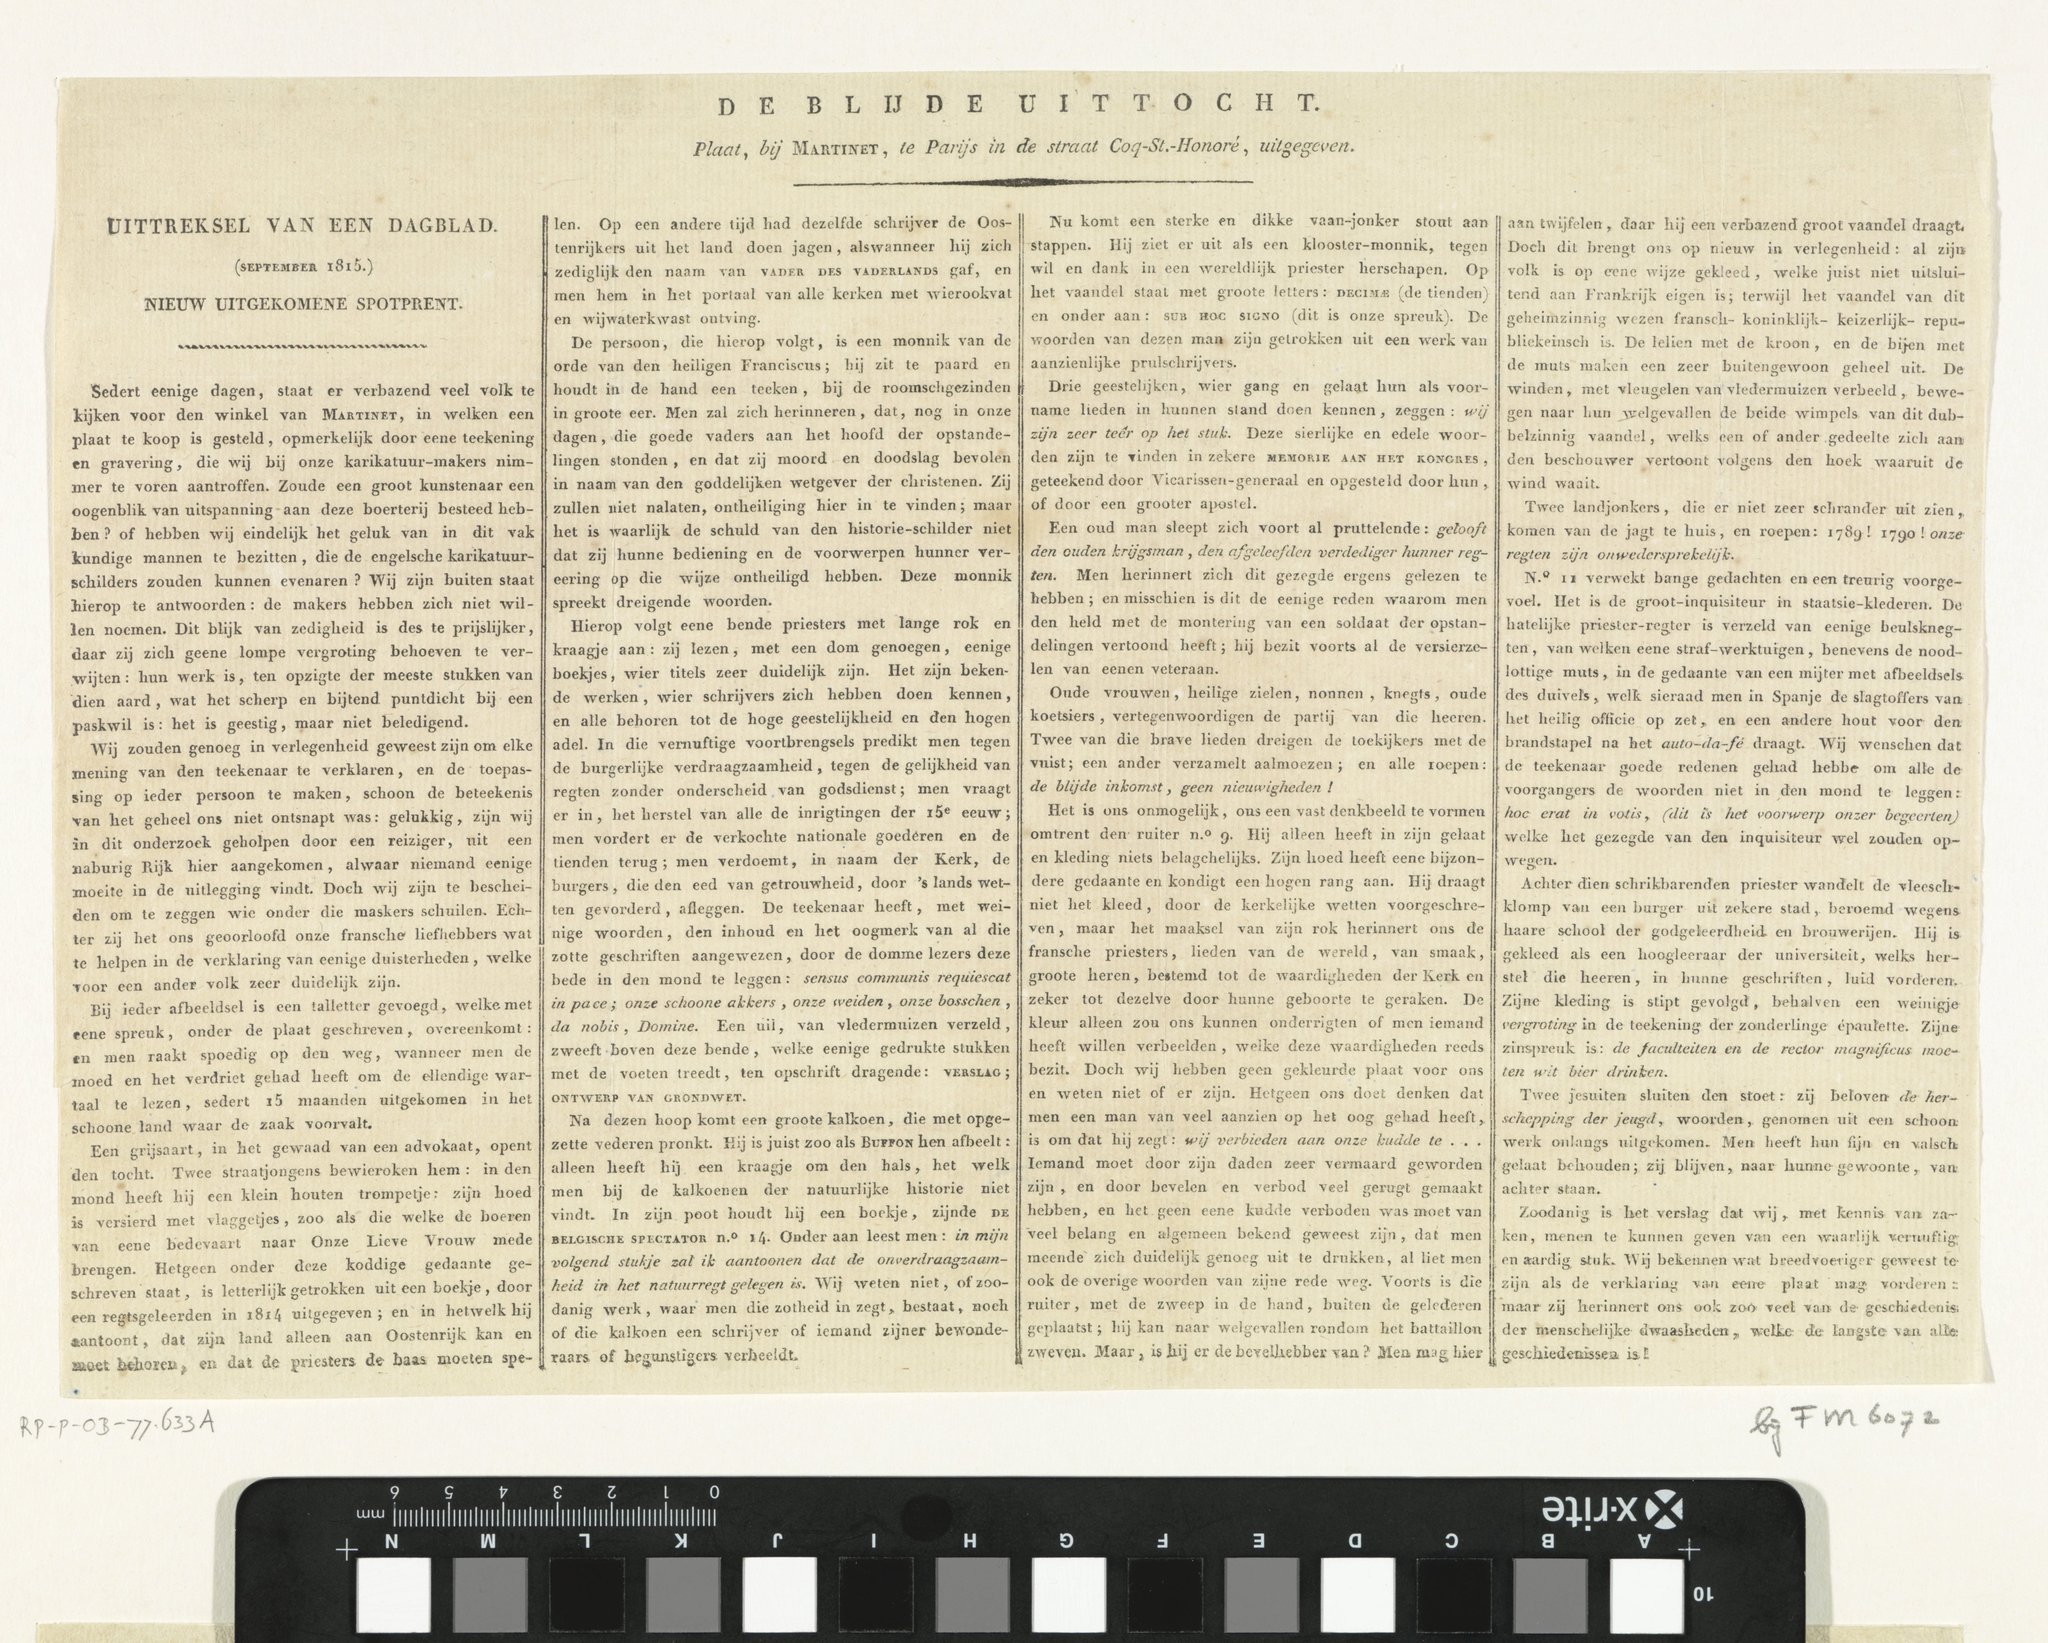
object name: text sheet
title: De blijde uittocht, 1815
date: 1809-1815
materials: paper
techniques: letterpress printing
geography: paris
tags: bevrijding van nederland (1815)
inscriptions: collector's mark: Lugt 2228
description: Tekstblad behorend bij de spotprent op het vertrek van de Fransen uit Nederland, 1815. Tekst in vier kolommen in het Nederlands.